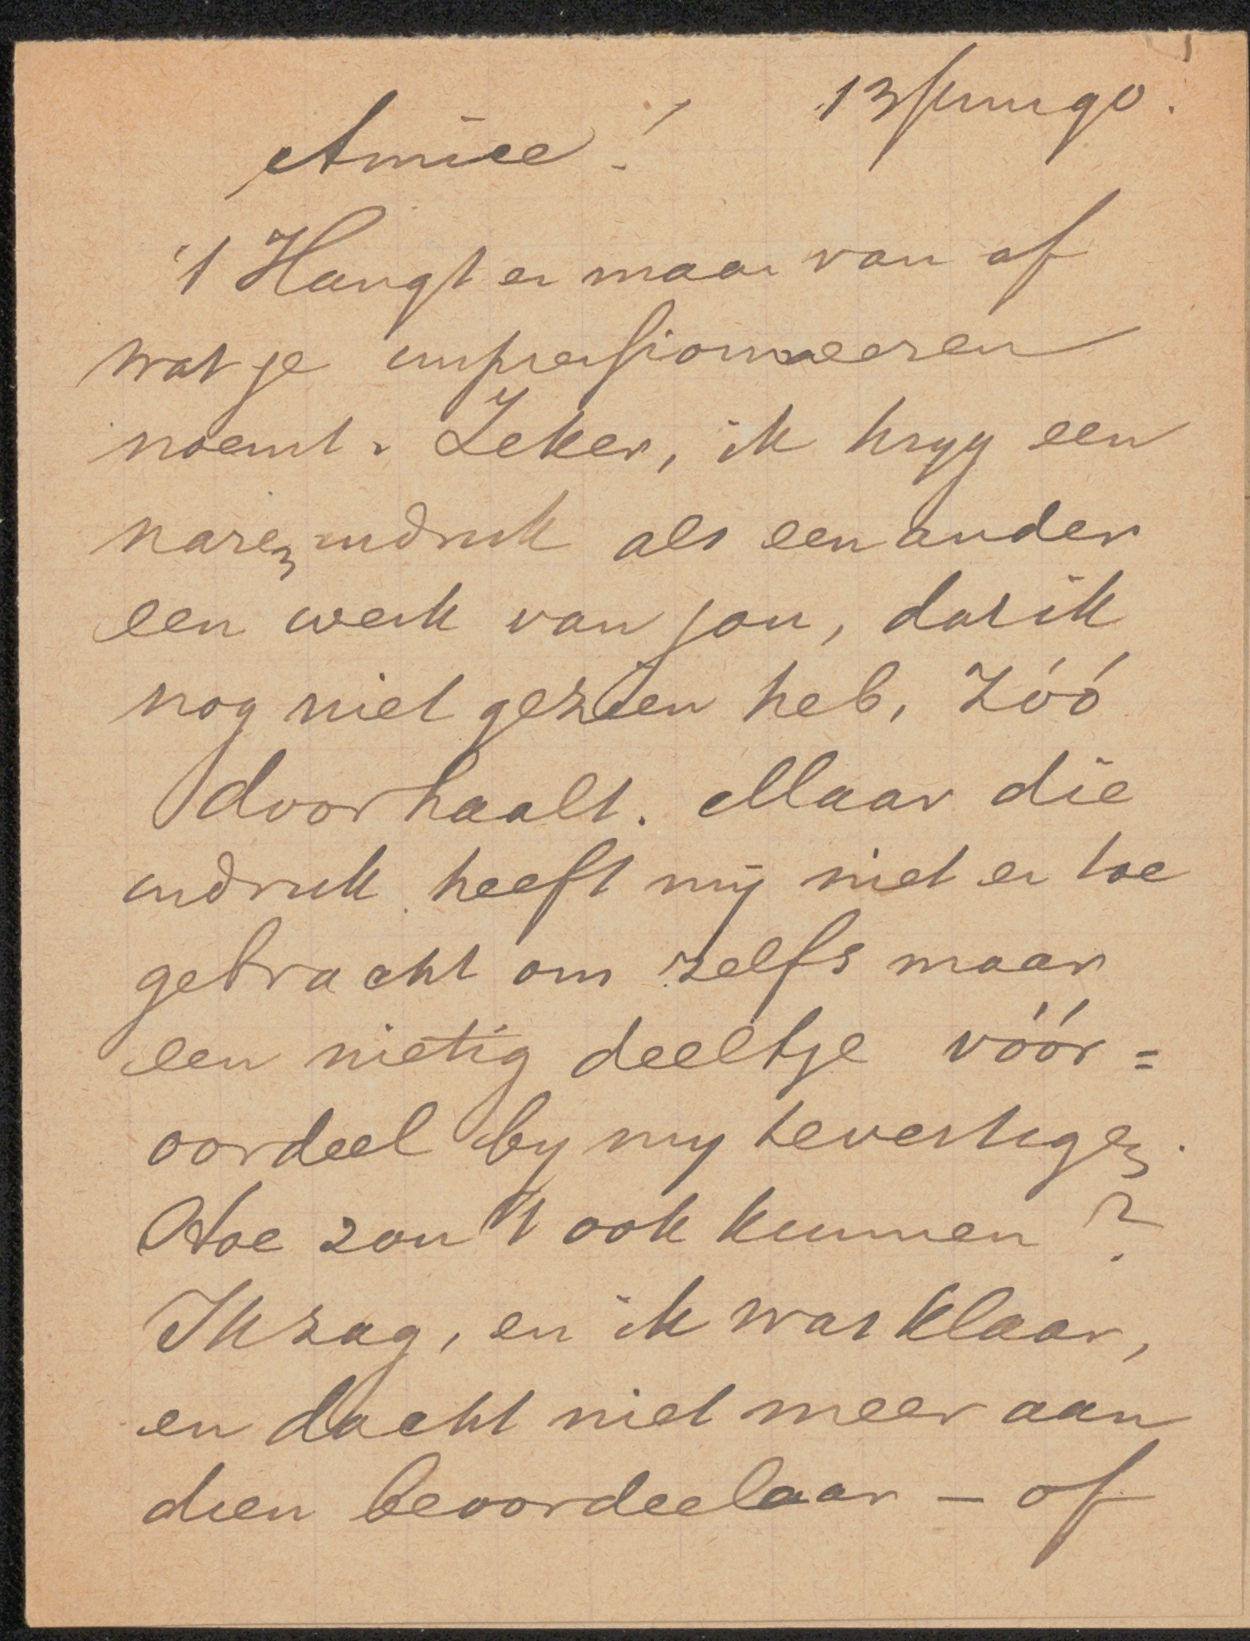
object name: letter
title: Brief aan Jan Veth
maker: martinus cornelis lebret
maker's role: verzamelaar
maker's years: 1833-1894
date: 1890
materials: ink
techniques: pen, writing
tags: the hague, jozef israëls, daubigny, dordrecht, amsterdam, painter, print maker, draughtsman, designer, jan veth, paris, camille corot, arnhem, anton mauve, jean françois millet, exhibition ~ art, rotterdam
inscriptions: collector's mark: ‘RPK’